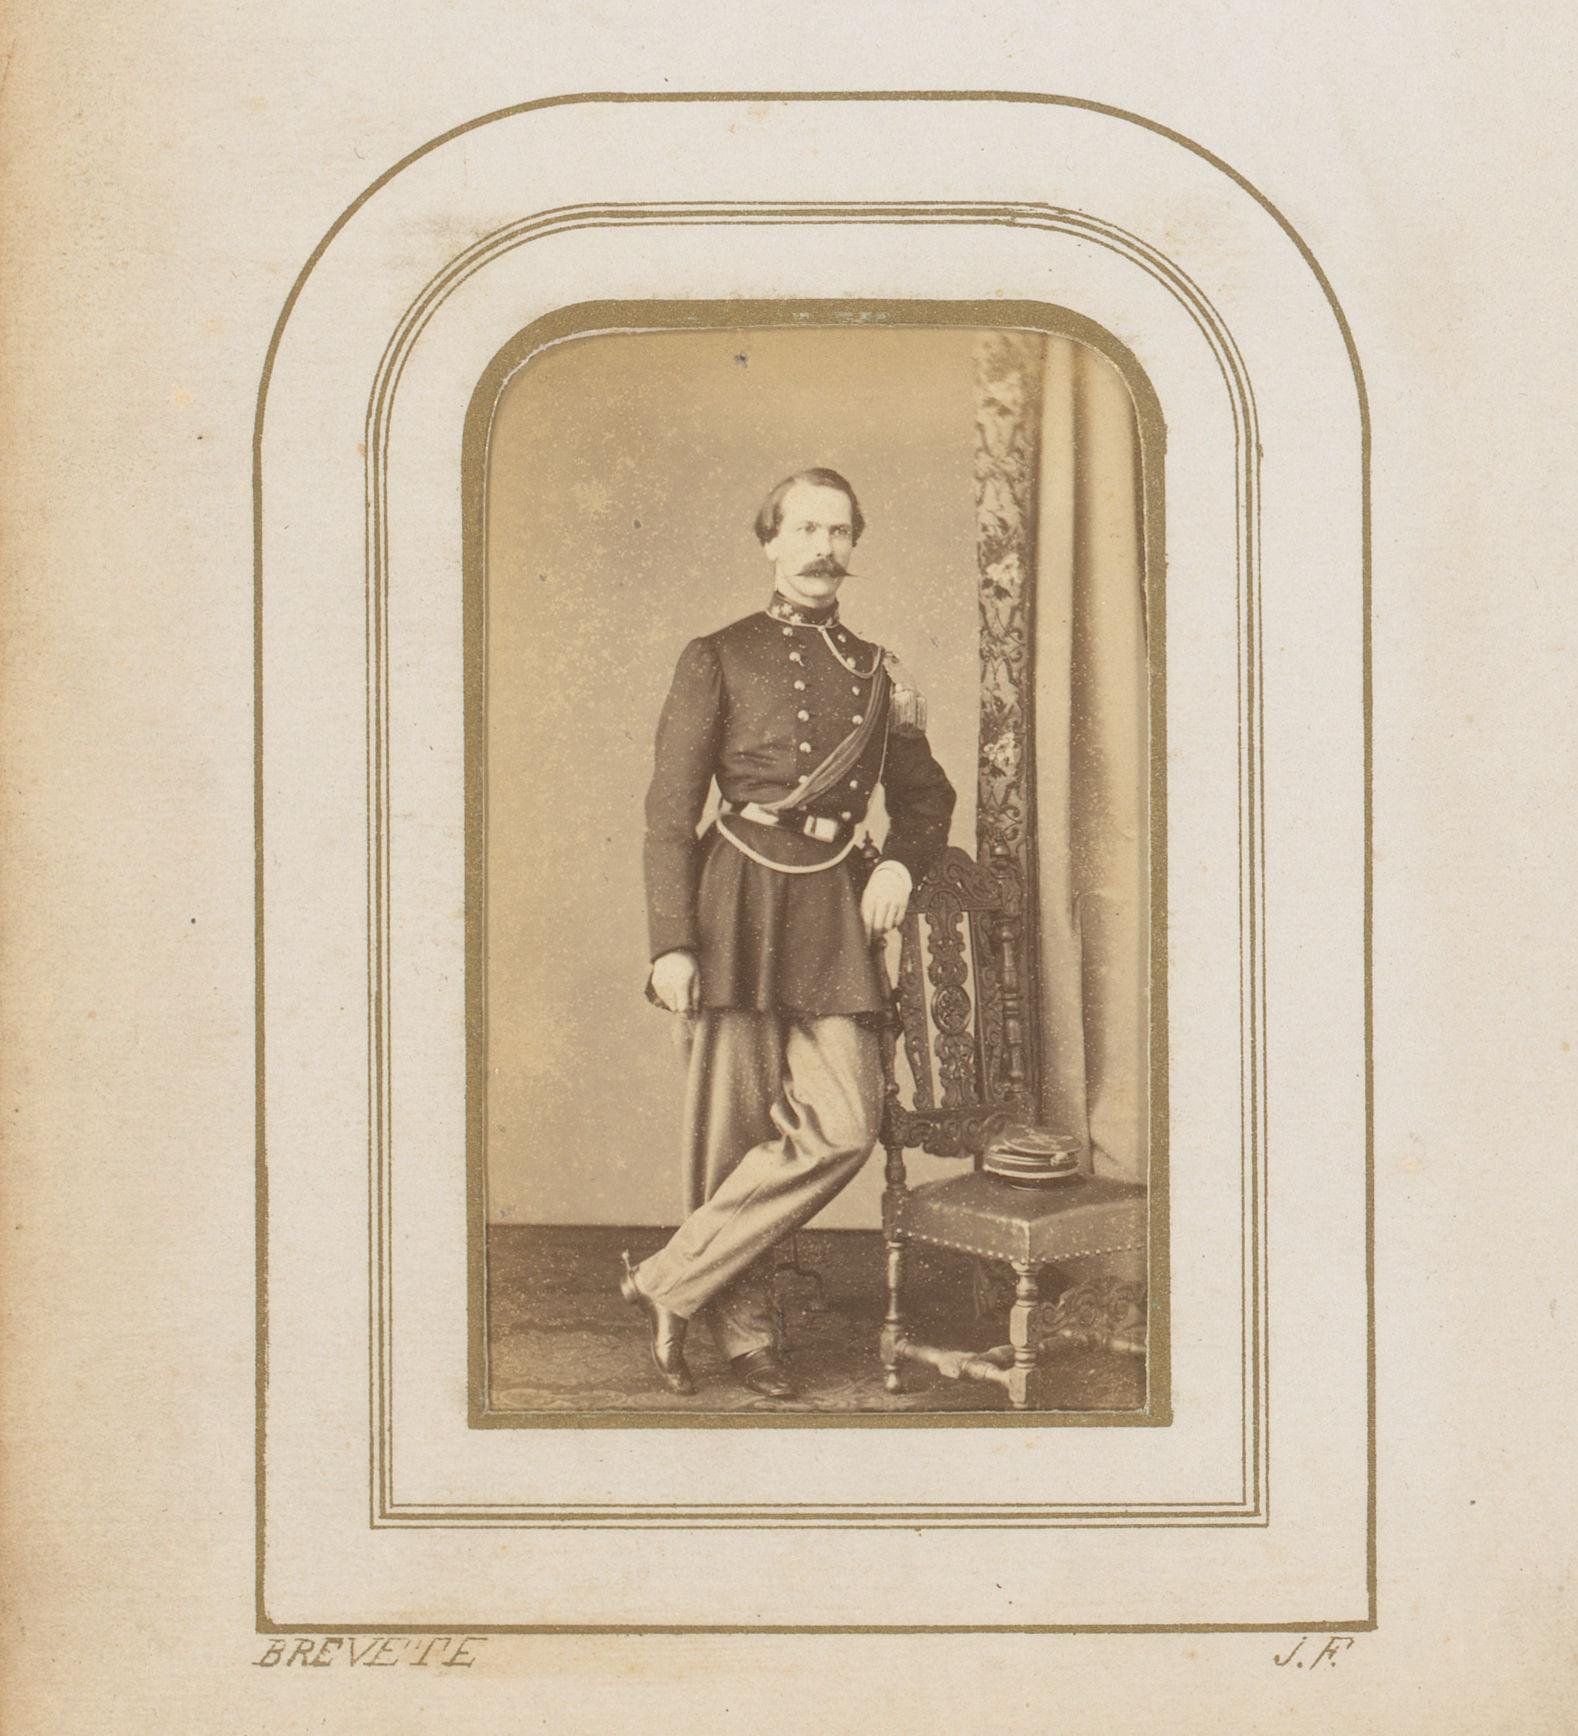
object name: album leaf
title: Portret van een man in uniform, staand bij een stoel met hoed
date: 1862-1863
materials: cardboard, photographic support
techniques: albumen print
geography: brussels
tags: moustache, historical persons, (military) uniforms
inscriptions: inscription: ‘Establissement Photographique/ de Maes & Michaux/ Place de la Monnaie, 36, Rue Fossé-aux-Loups’